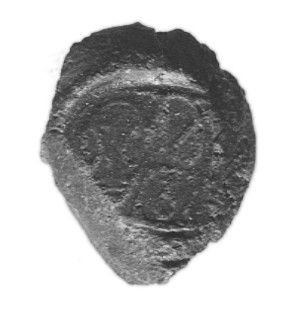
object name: sealing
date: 2030-1640 BCE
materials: clay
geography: egypt